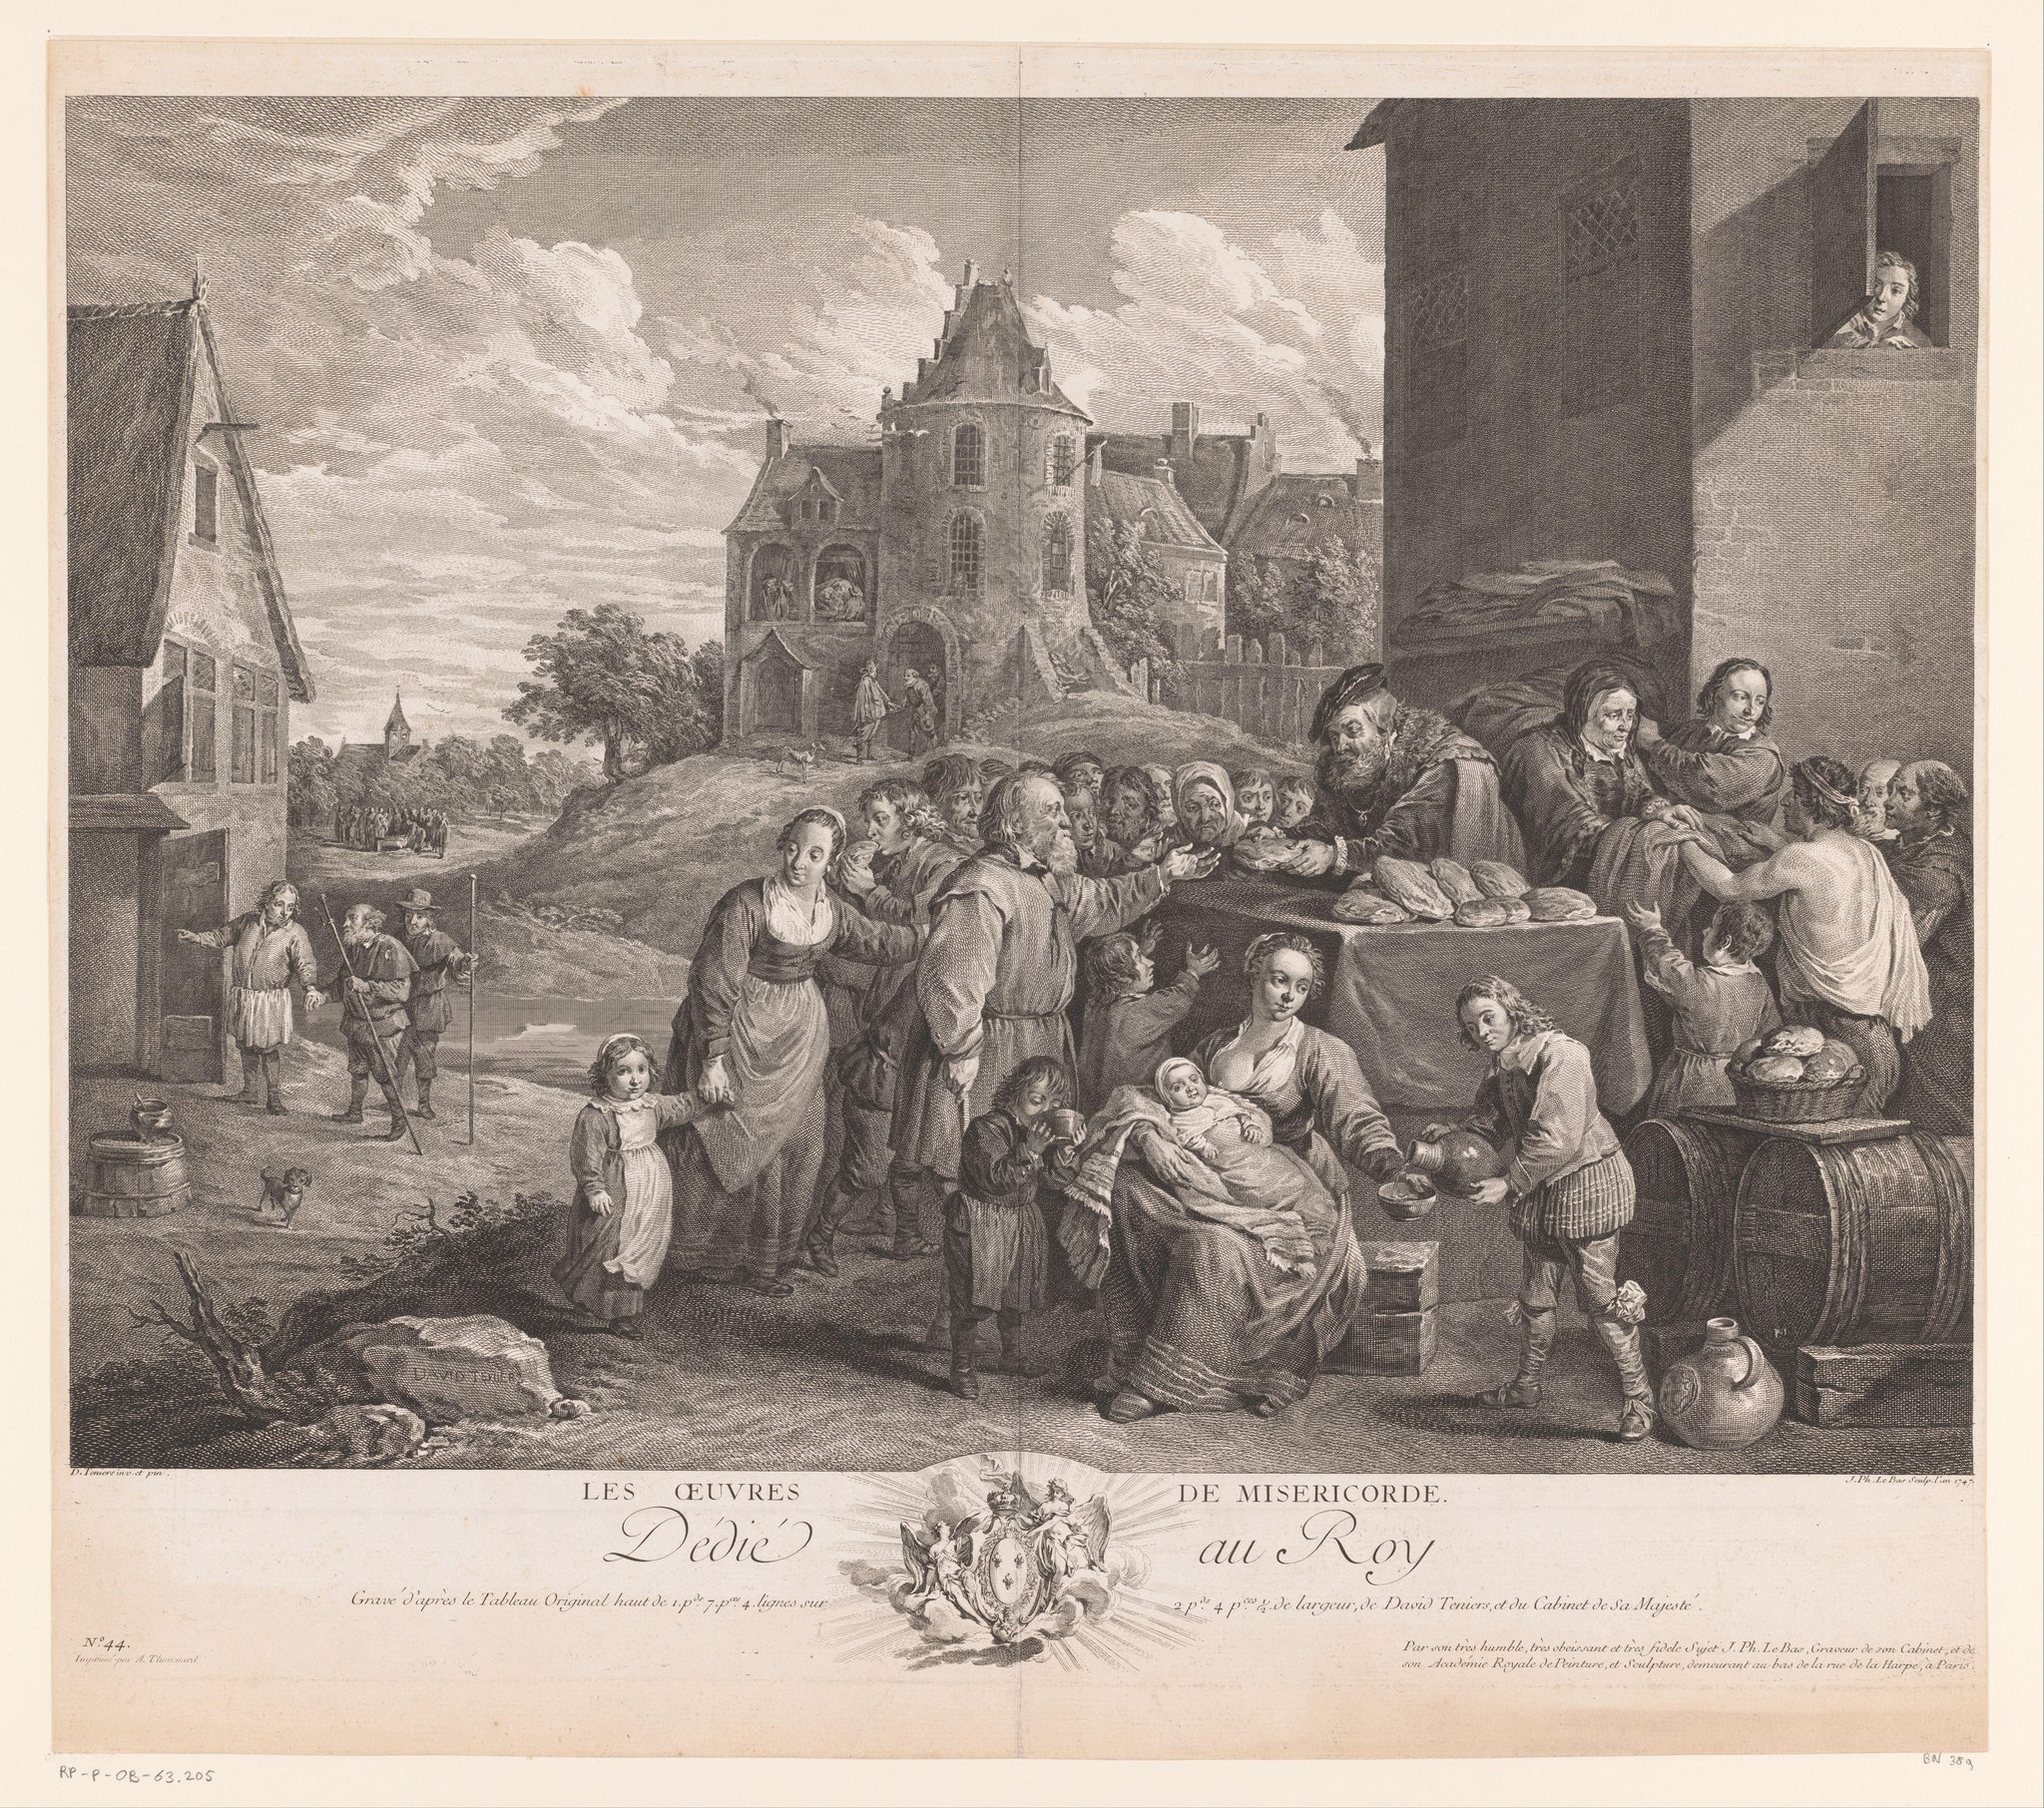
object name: print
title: Zeven werken van barmhartigheid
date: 1747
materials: paper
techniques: engraving, etching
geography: france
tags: village, the (seven) acts of mercy, mercy, compassion; 'compassione', 'misericordia' (ripa)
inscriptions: collector's mark: Lugt 240